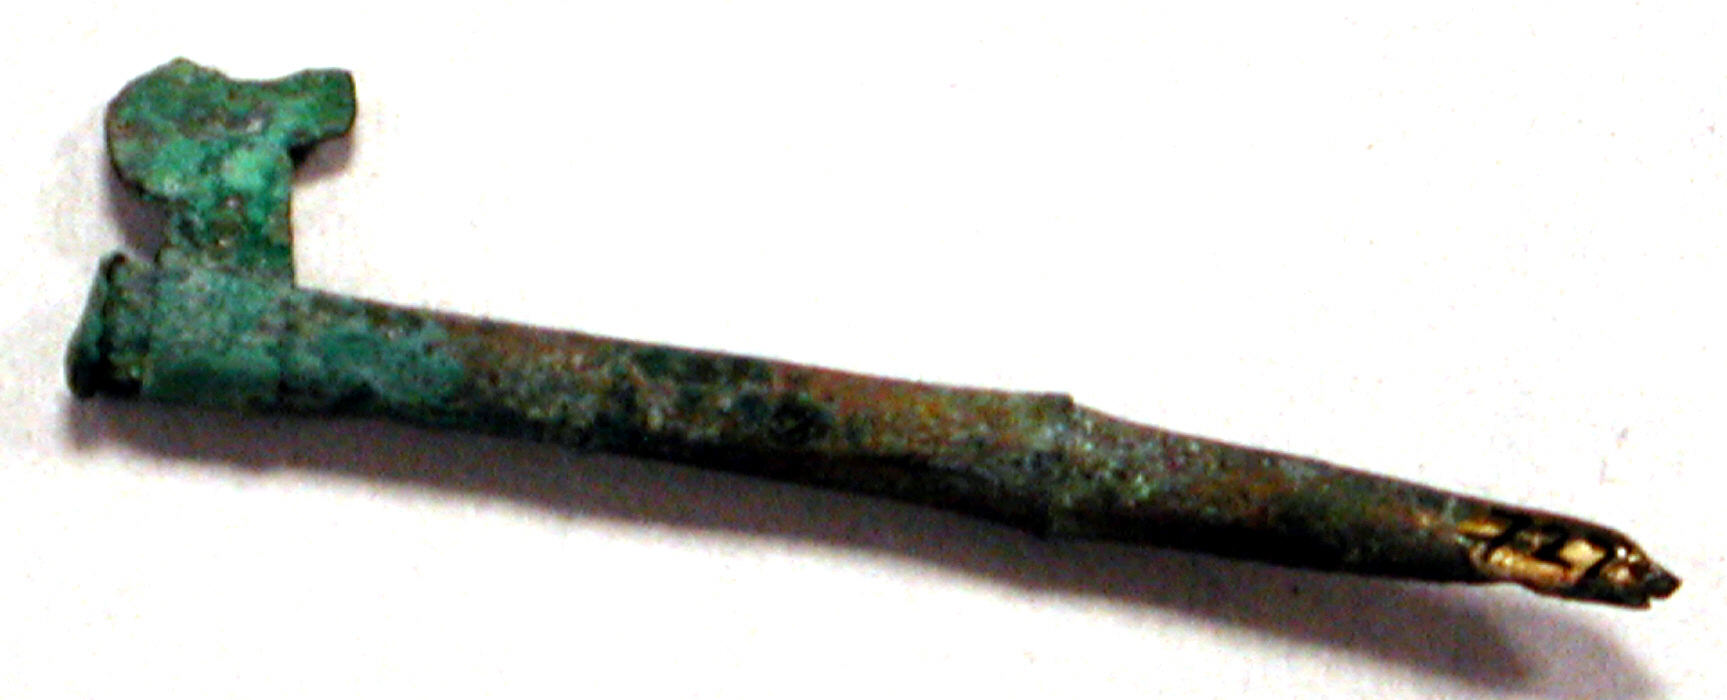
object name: spear thrower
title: Hammered Silver Miniature Spear Thrower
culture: peruvian, north or central coast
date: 701-1566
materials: gilt, silver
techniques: hammering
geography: peru